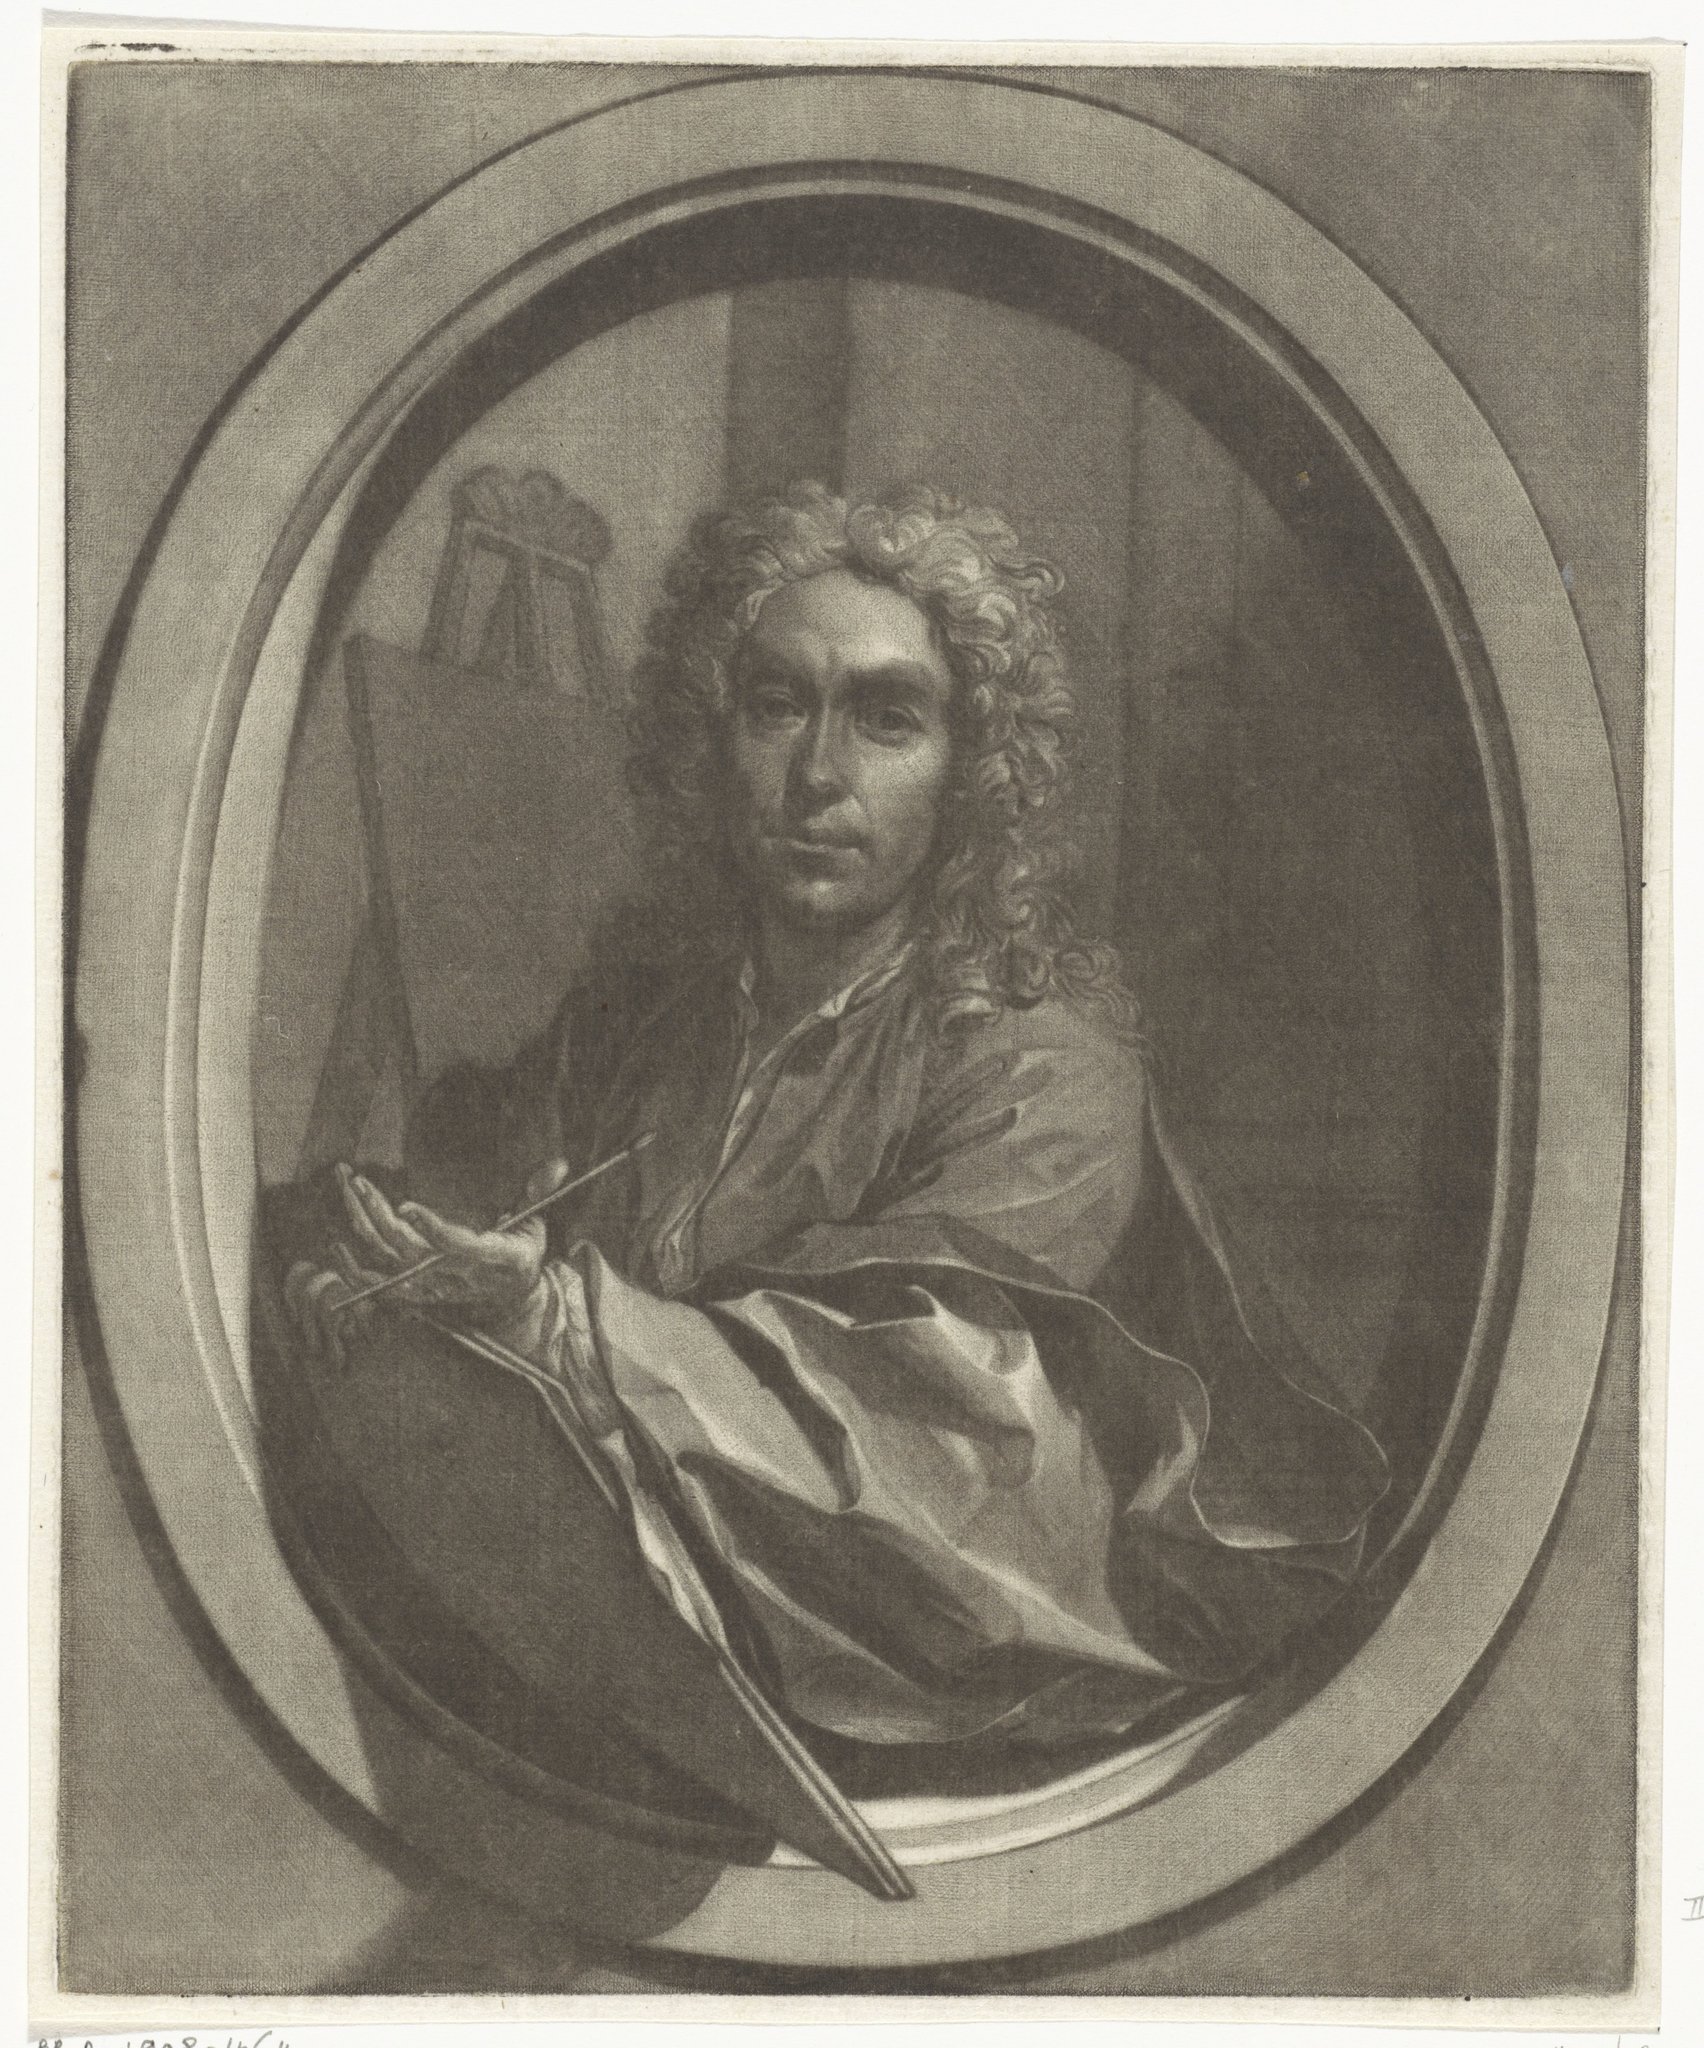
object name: print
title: Portret van Nicolaas Verkolje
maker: arnout rentinck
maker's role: draughtsman, print maker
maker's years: 1712-1774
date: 1753-1763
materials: paper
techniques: mezzotint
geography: amsterdam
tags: delft, painter, print maker, nicolaas verkolje, portrait, self-portrait of painter, tools, implements of painter, wig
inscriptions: collector's mark: Lugt 2228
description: De schilder, tekenaar en prentmaker Nicolaas Verkolje met een penseel en een portefeuille. Op de achtergrond een schildersezel.